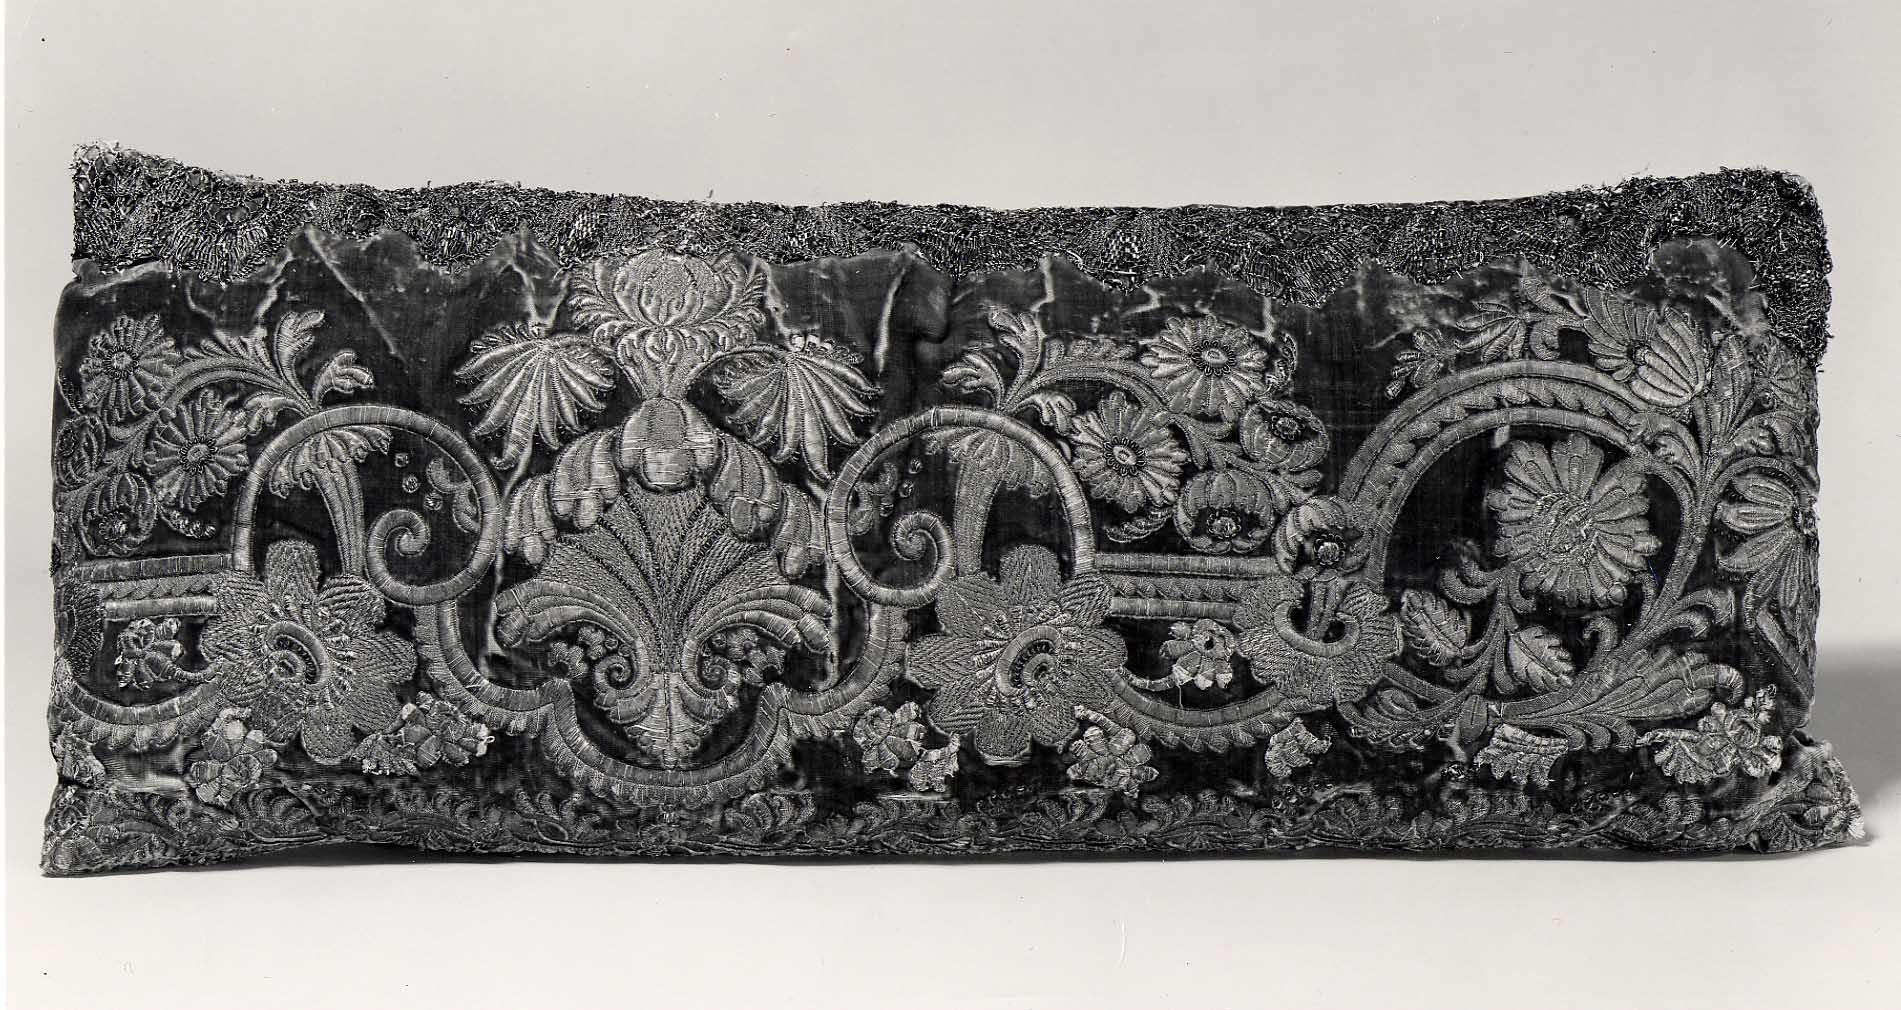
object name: cushion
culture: french or italian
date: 1601-1700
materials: animal substrate, metal, silk